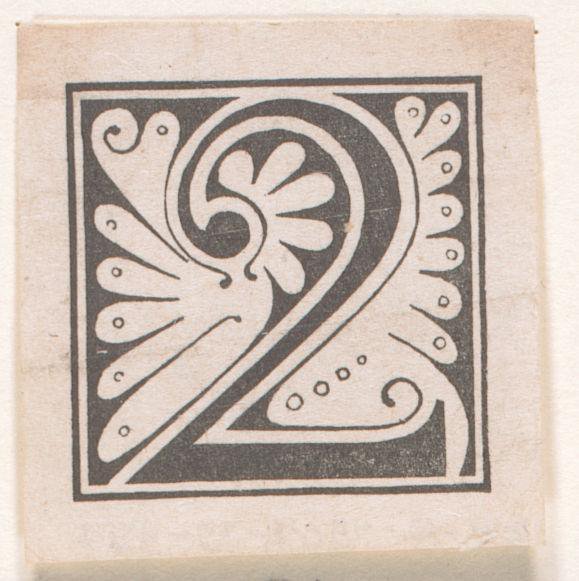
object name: photomechanical print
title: Getal 2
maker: reinier willem petrus de vries (1874-1953)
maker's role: draughtsman, print maker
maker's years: 1874-1953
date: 1904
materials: paper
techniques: printing block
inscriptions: collector's mark: ‘R:MVS.’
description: Het getal is gebruikt voor: Veth, Jan. Jozef Israëls en zijn kunst. Arnhem en Nijmegen: Gebroeders E&M Cohen, 1904.